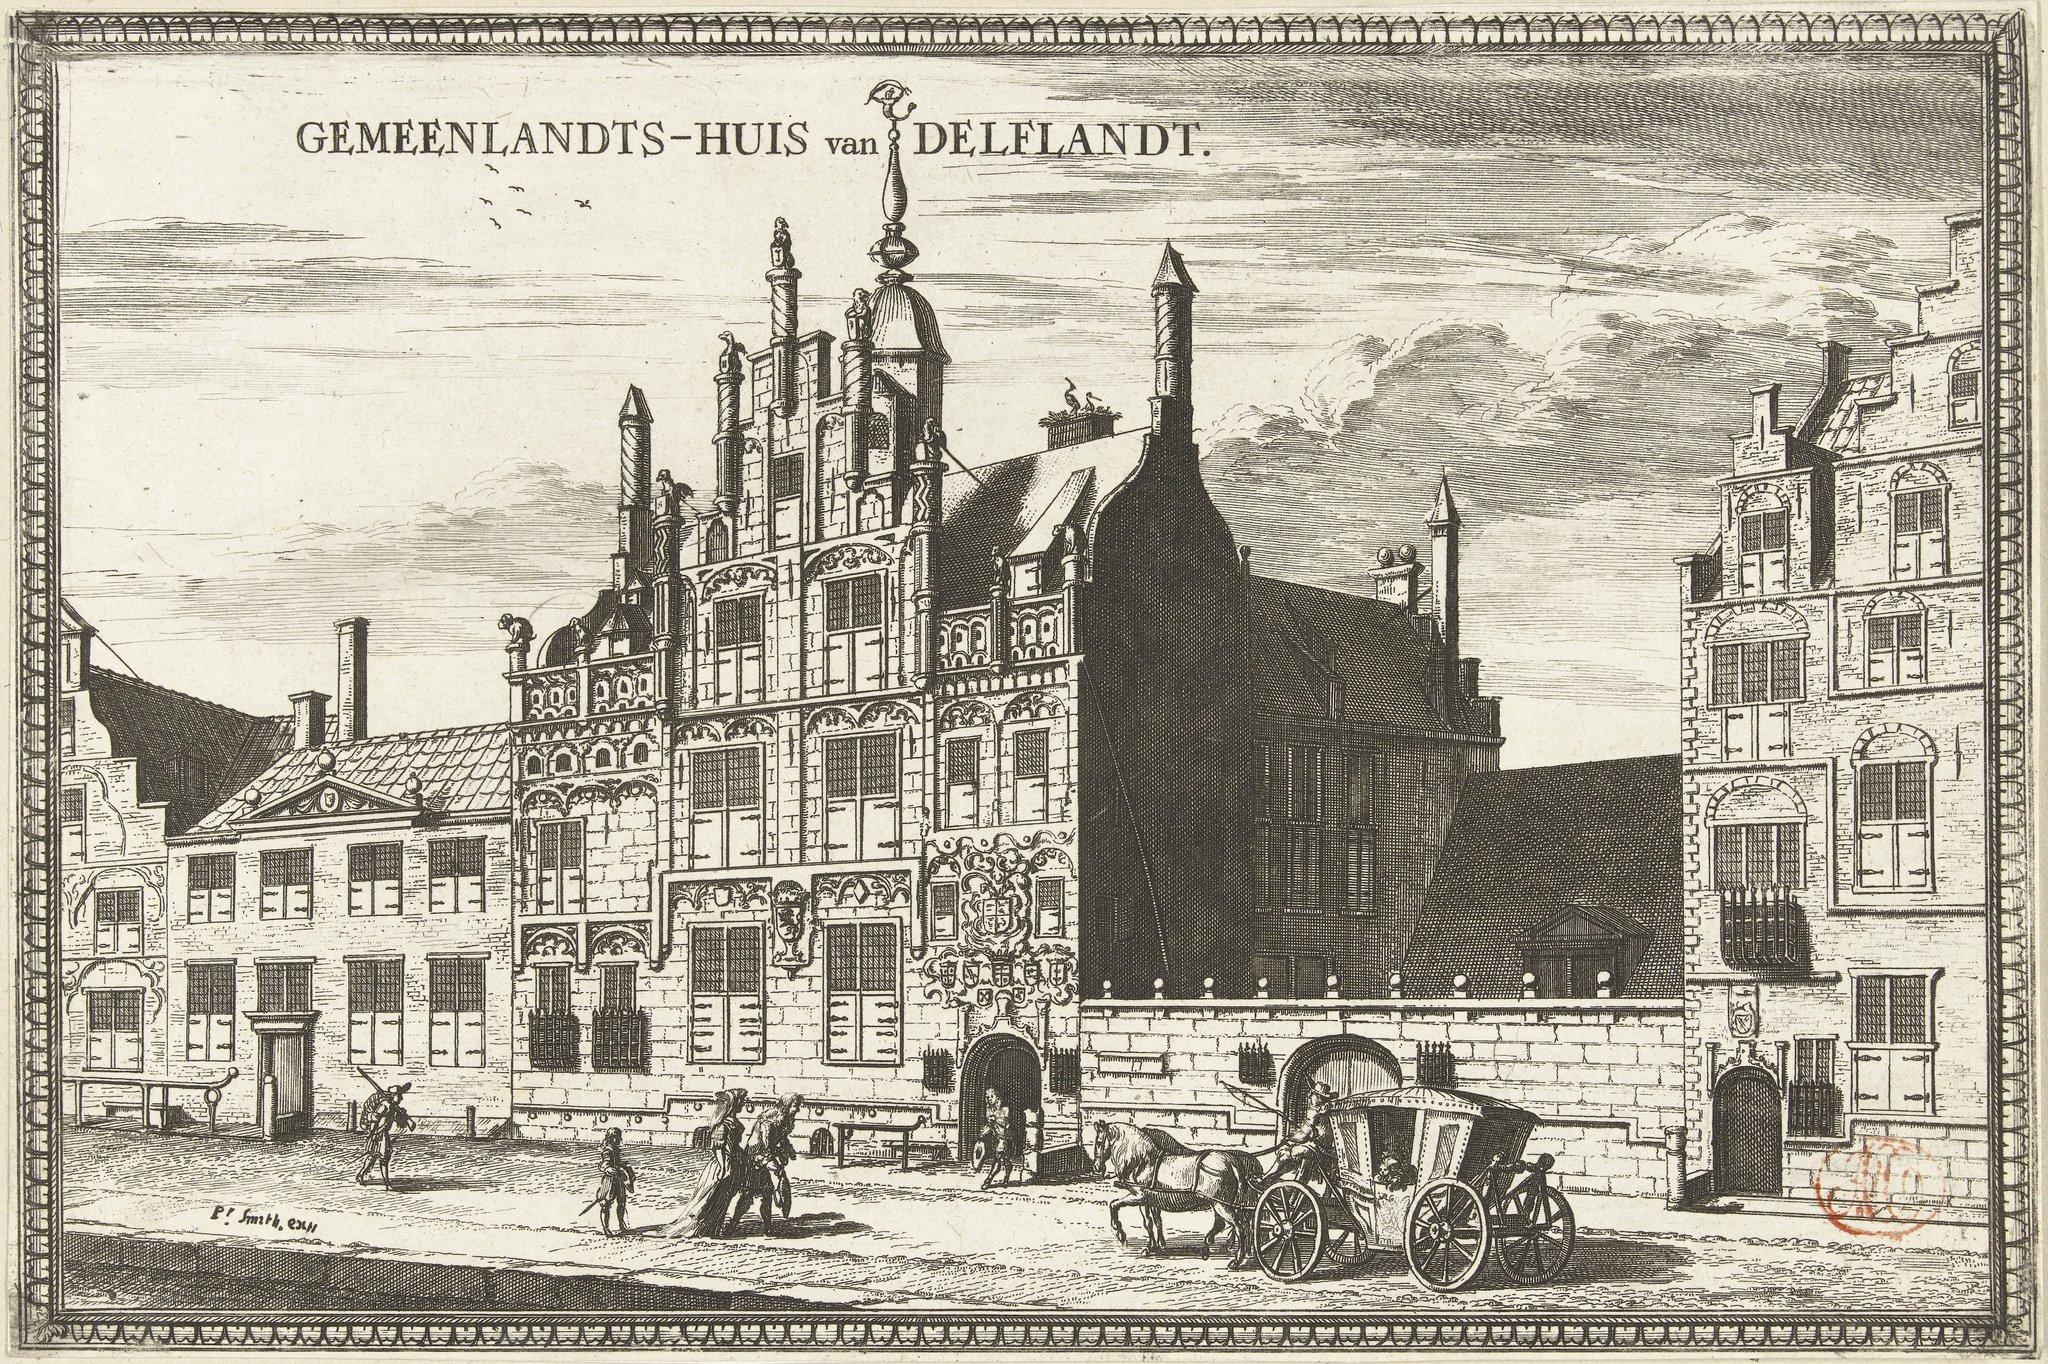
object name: print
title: Gemeenlandts-huis van Delflandt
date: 1678-1703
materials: paper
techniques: etching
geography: amsterdam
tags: exterior ~ representation of a building, street (+ city(-scape) with figures, staffage)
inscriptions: collector's mark: Lugt 195, collector's mark: Lugt 2228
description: Deze prent is in 1678 voor het eerst uitgegeven als onderdeel van de rand van de zogenaamde Kaart Figuratief (Caerte figuratyff / Kaerte figuratyf) van Delft, een wandkaart van Delft. Deze kaart bestaat uit een plattegrond van Delft (RP-P-AO-11-8A) met daaromheen een rand. De rand bestaat uit een profiel van Delft (RP-P-AO-11-11), een profiel van Delfshaven met daaronder de wapenschilden van de burgemeesters van de stad (RP-P-AO-13-51-1 en RP-P-AO-13-51-2), 24 kleinere prenten (kaarten, afbeeldingen van gebouwen en graven van bekende personen, o.a. huidige prent, RP-P-AO-11-15, RP-P-AO-11-16, RP-P-AO-11-17, RP-P-AO-11-19, RP-P-AO-11-20, RP-P-AO-11-21, RP-P-AO-11-23, RP-P-AO-11-24, RP-P-AO-11-27, RP-P-AO-11-28, RP-P-AO-11-29, RP-P-AO-11-30, RP-P-AO-11-31, RP-P-AO-11-33C, RP-P-AO-11-34, RP-P-AO-11-35, RP-P-AO-11-35-2, RP-P-AO-13-49, RP-P-AO-13-52, RP-P-AO-13-53, RP-P-AO-13-54-1 en RP-P-1909-6463) en een beschrijving van de stad (RP-P-AO-11-8E). De eerste druk van deze Kaart Figuratief (1678) werd, in opdracht van het Delftse stadsbestuur, verzorgd door Pieter Smith. In 1680 leverde Smith ook vijfhonderd afdrukken van de randprenten die bestemd waren voor Dirk Evertsz. Bleyswijcks 'Beschryvinge der stadt Delft' (1667) en het tweede deel: 'Vervolg van de beschryvinge der stadt Delft' (1680). In het tweede deel zat een bijlage waarin beschreven staat welke prenten waar in het eerste en tweede deel ingebonden dienden te worden. Een deel van de prenten was dus bestemd voor het in 1667 verschenen eerste deel en kon met het verschijnen van het tweede deel in 1680 alsnog worden ingebonden. Hierdoor wordt vaak gedacht dat de prenten uit het eerste deel dateren uit 1667, hetgeen niet klopt. De huidige prent is zodoende ook gebruikt in: Bleyswijck, Dirk Evertsz. Vervolg van de beschryvinge der stadt Delft, met een generael register over beyde stucken voorsien. Delft: Arnold Bon, 1680, p. 552. Pieter Mortier (I) verzorgde in 1703, tevens in opdracht van het stadsbestuur, een tweede uitgave van de Kaart Figuratief. Voor deze druk bracht graveur Thomas van der Wilt enkele aanpassingen aan op de platen van de plattegrond. De randplaten lijken, op de plaat met de wapens van de burgemeesters na, ongewijzigd te zijn gebleven. De plattegrond is in 1752, waarschijnlijk zonder de randprenten, opnieuw uitgegeven. Een deel van de randprenten, waaronder de huidige prent, is in 1729 opnieuw gebruikt in: Beschryving der stadt Delft, behelzende een zeer naaukeurige en uitvoerige verhandeling van deszelfs eerste oorsprong (…). Delft: Reinier Boitet, 1729. Op twee na (die van de Nieuwe en Oude Kerk) paste Boitet de platen aan, waardoor van deze prenten een tweede staat ontstond. Of de huidige prent is gebruikt als onderdeel van de rand van de Kaart Figuratief uit 1678 of 1703, of is gebruikt in 'Vervolg van de beschryvinge der stadt Delft' (1680), is niet na te gaan.